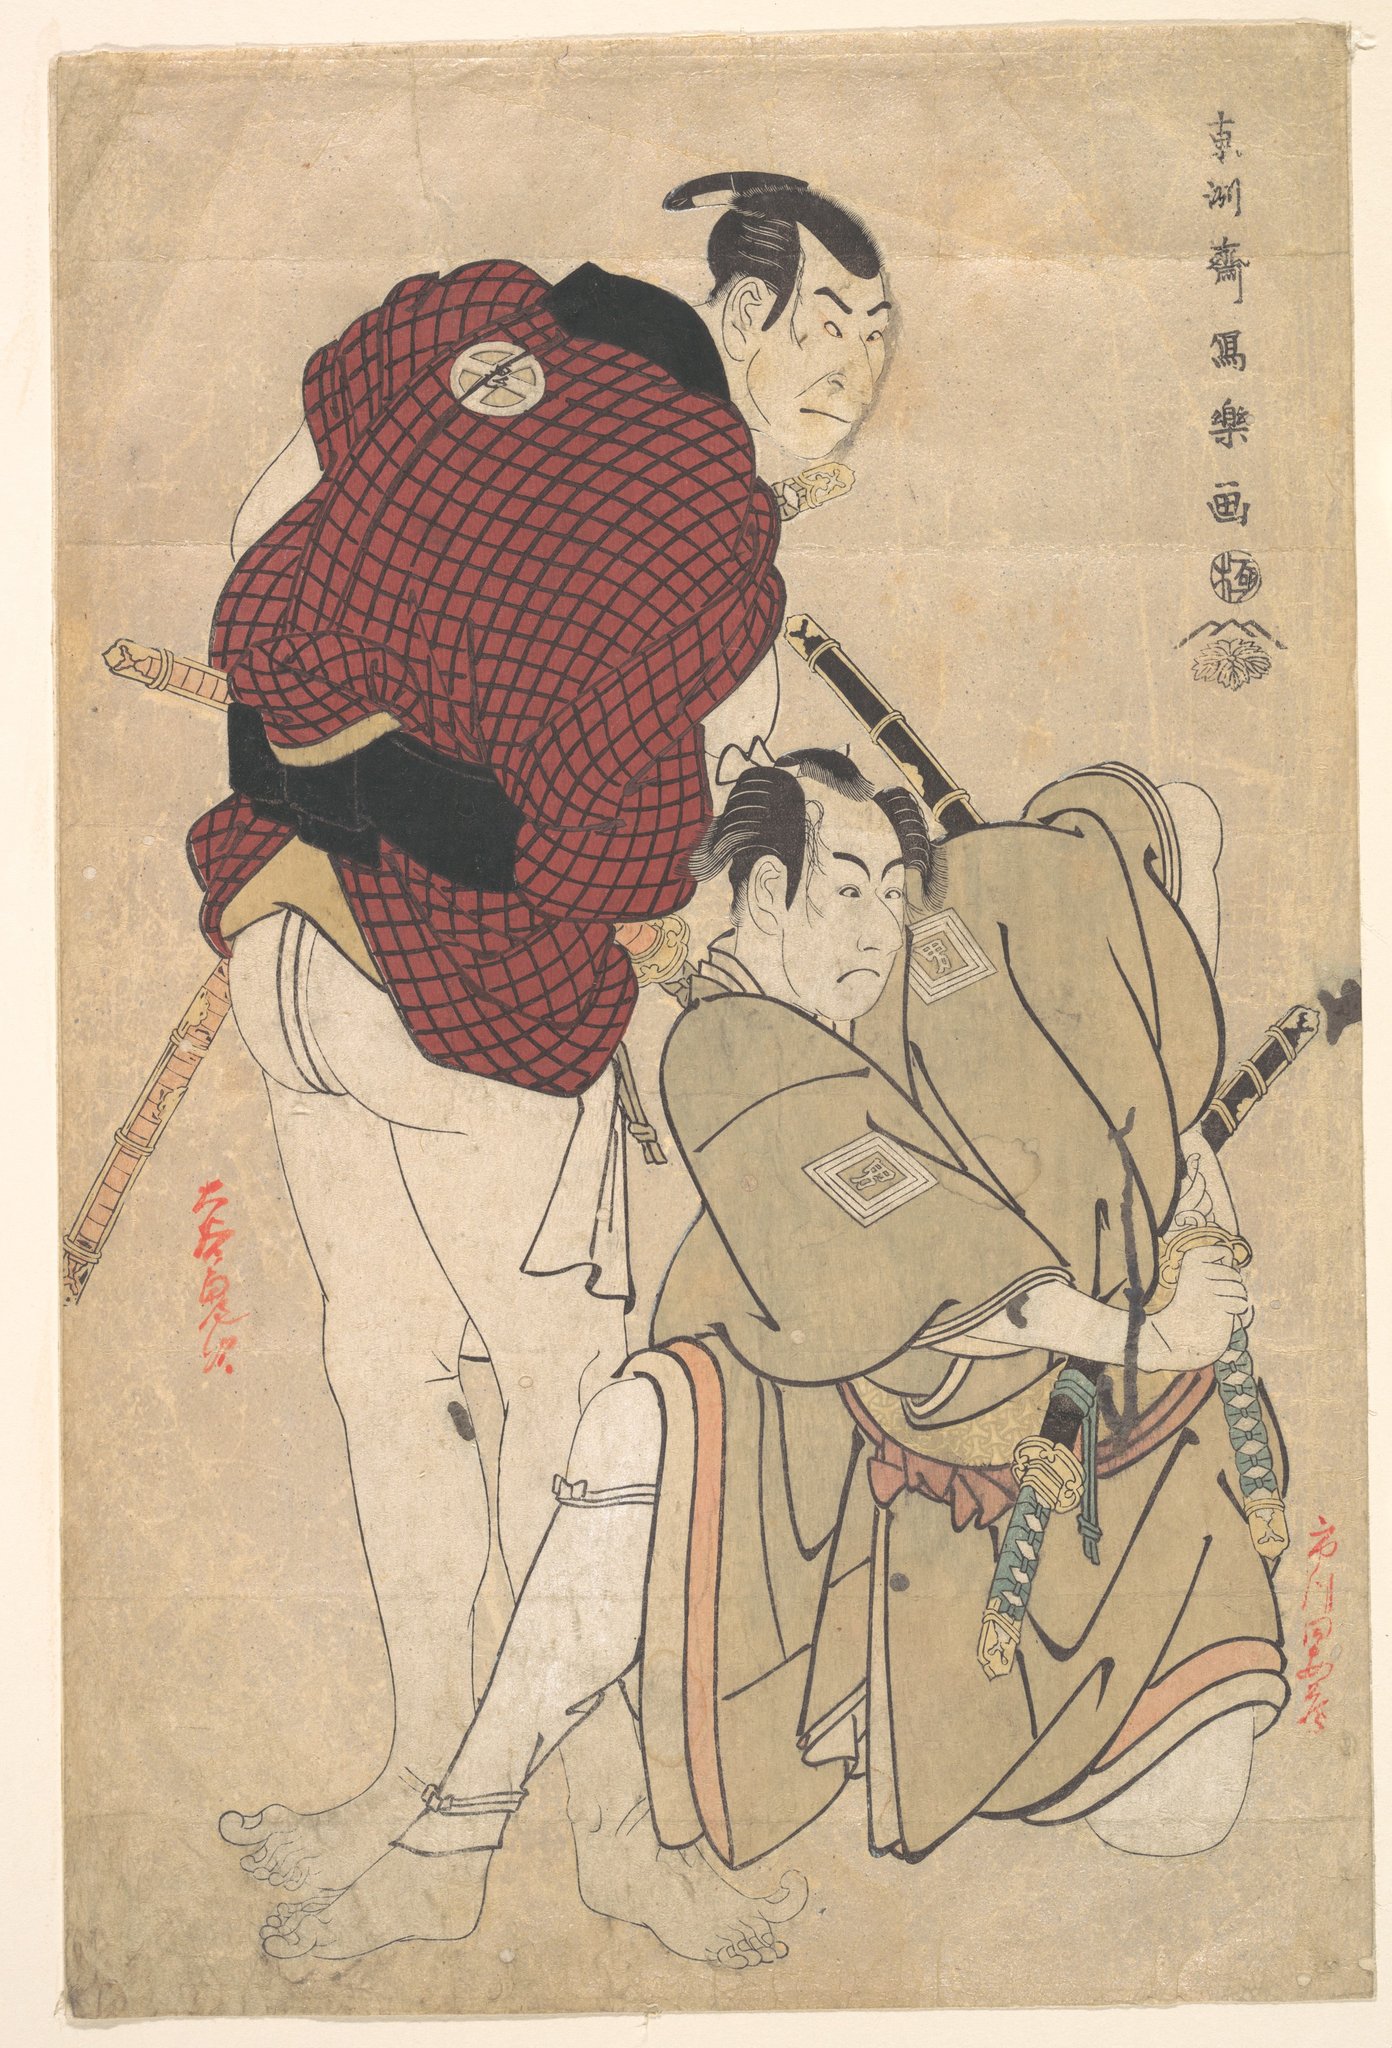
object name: print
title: Ichikawa Omezō as Tomita Hyōtarō and Ōtani Oniji III as Ukiyo Tohei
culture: japanese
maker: tōshūsai sharaku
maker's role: artist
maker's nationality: japanese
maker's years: 1794-1795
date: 1794-1795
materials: ink, mica, paper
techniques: woodblock print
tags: swords,men,actors